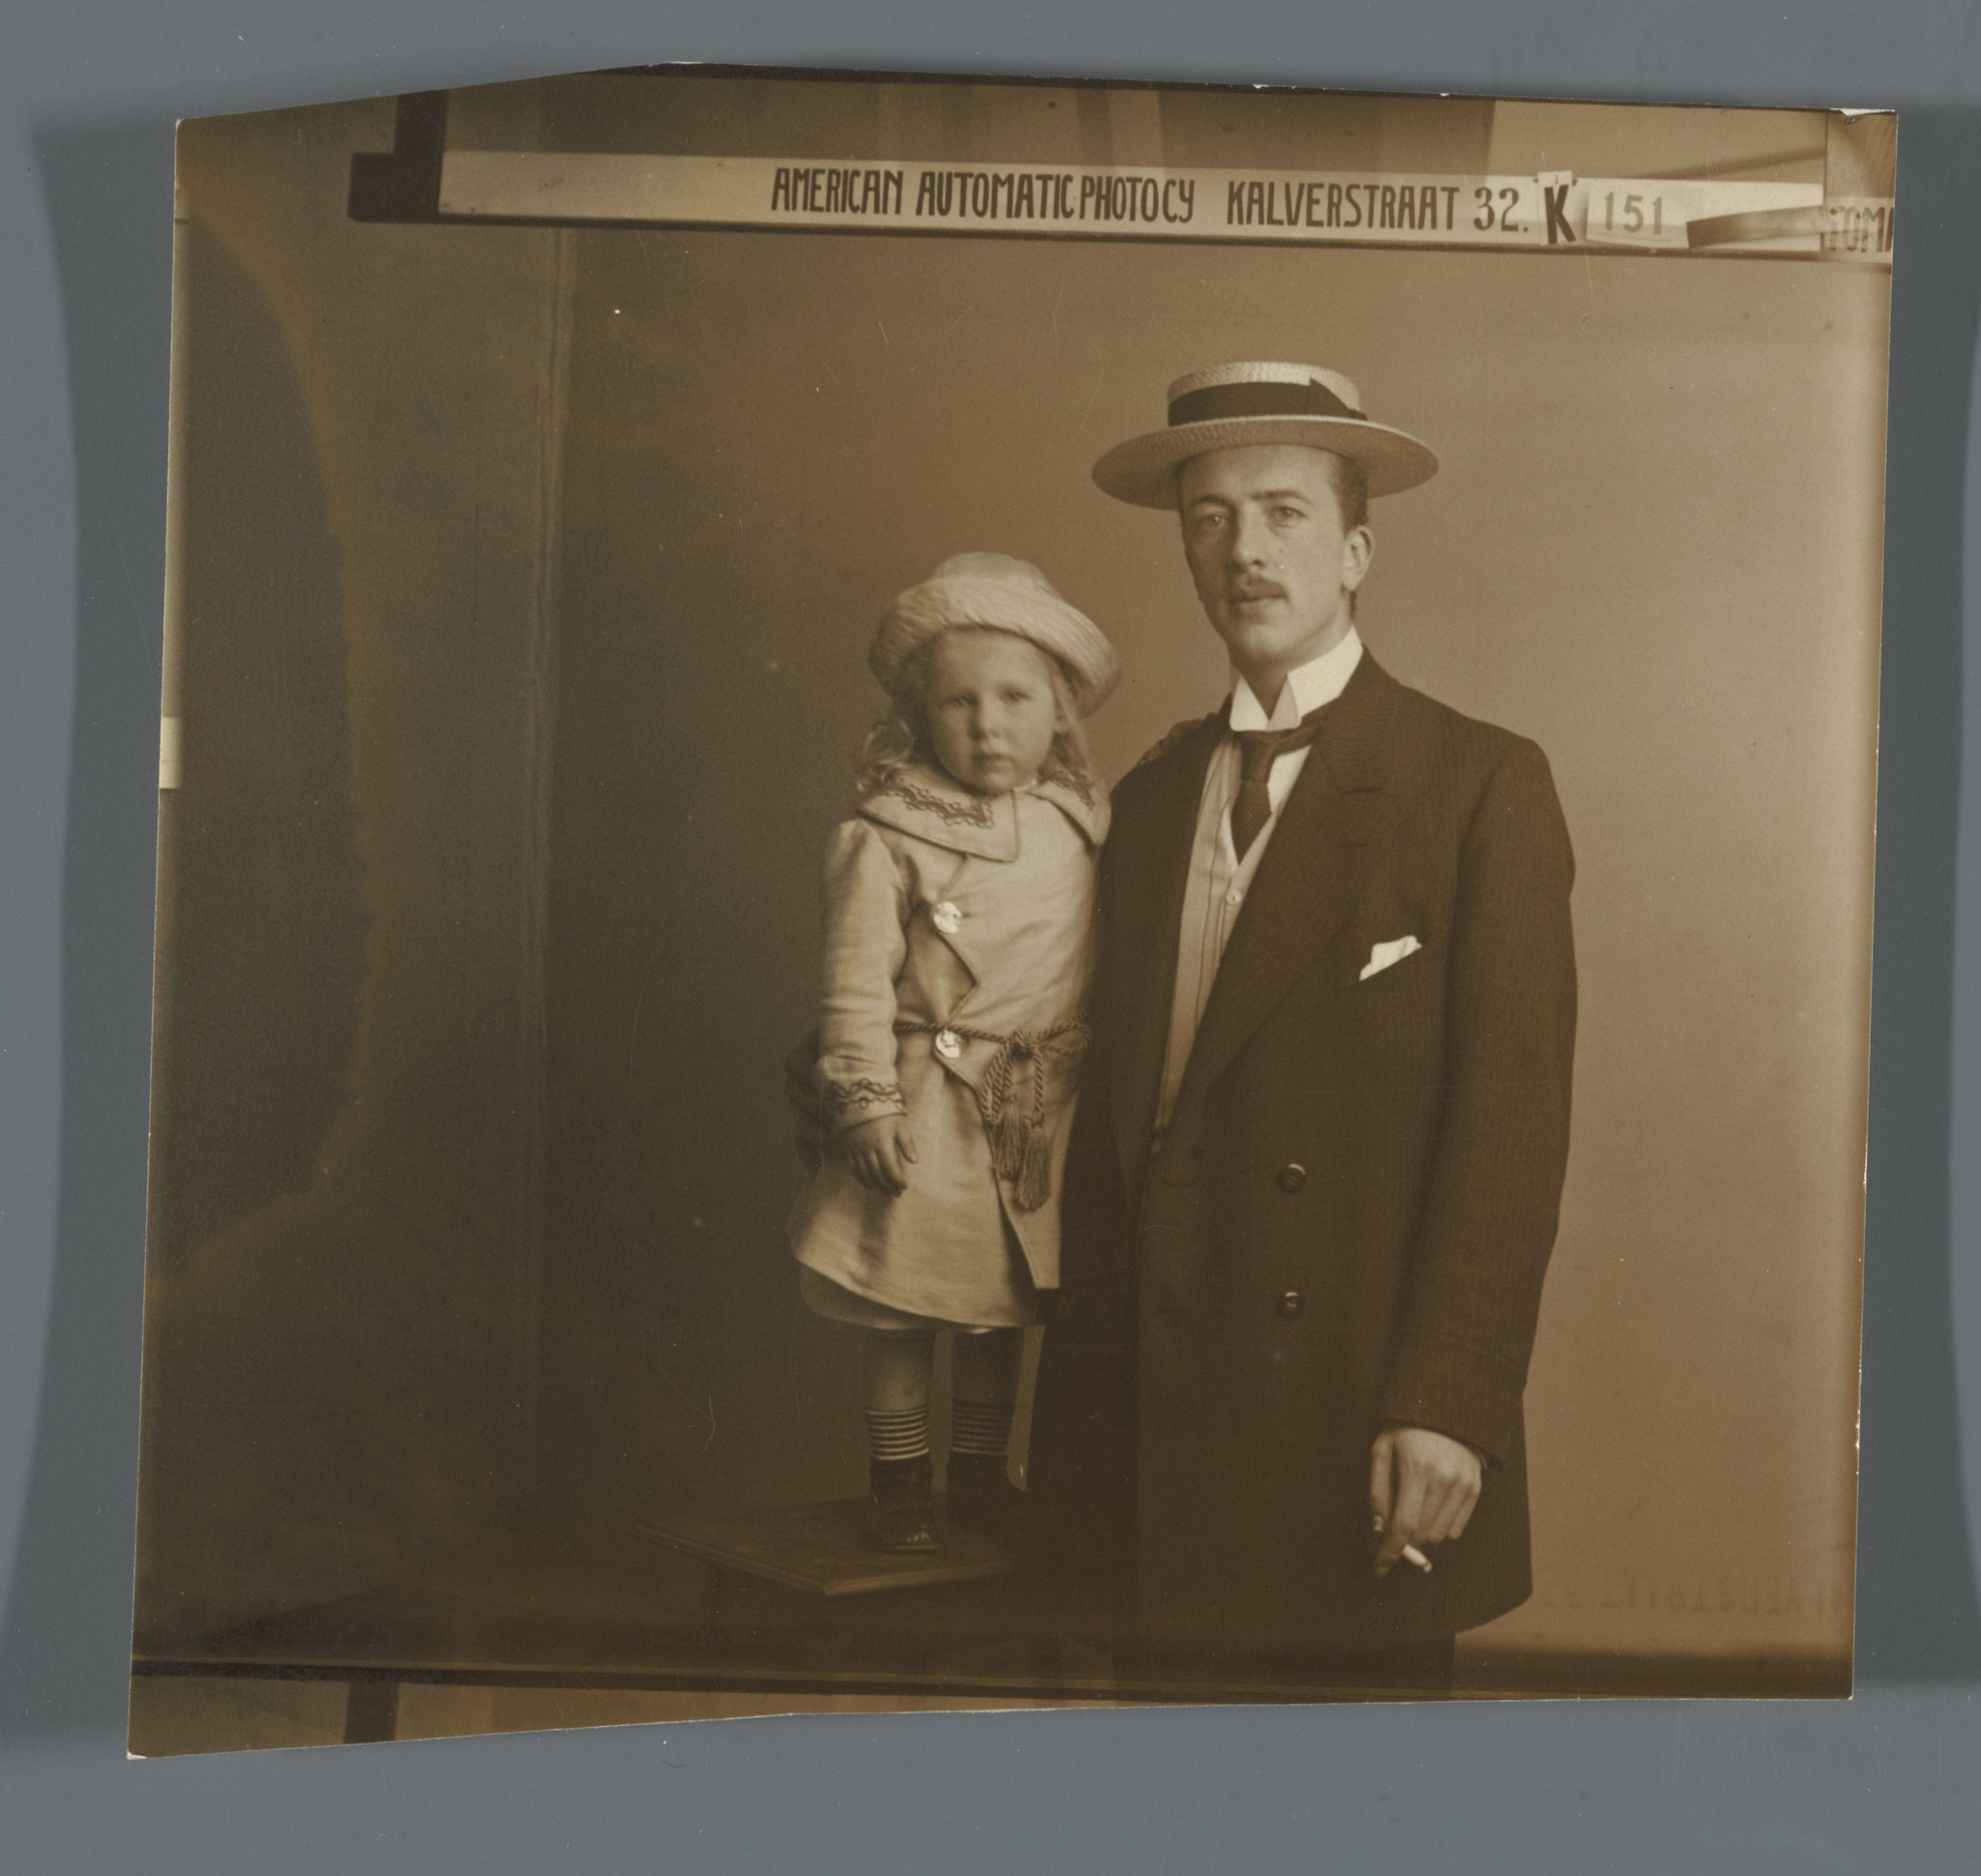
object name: snapshot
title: Rapid photographs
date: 1912-1918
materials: paper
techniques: gelatin silver print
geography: amsterdam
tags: child, historical persons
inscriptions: inscription: ‘AMERICAN AUTOMATIC PHOTO CY. KALVERSTRAAT 32 K 151’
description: Between 1912 and 1930, anyone could have their portrait taken at the many so-called rapid photography studios in the shopping streets of mainly (medium) large-size European cities. As if on an assembly line, the youngest clerk shot the photographs with a special camera and in artificial light and developed them. Later in the day, the customer collected a sheet with 12 portrait photos for 25 cents. This form of photographic mass production gave rise to a fascinating tableau of boys, girls, men and women not previously seen in photographs; candid and informal. There were at least 150 quick-photo studios, from Alkmaar to Zutphen. Many called themselves ‘American,’ mistakenly as it turns out because hardly any examples from that country have been found.